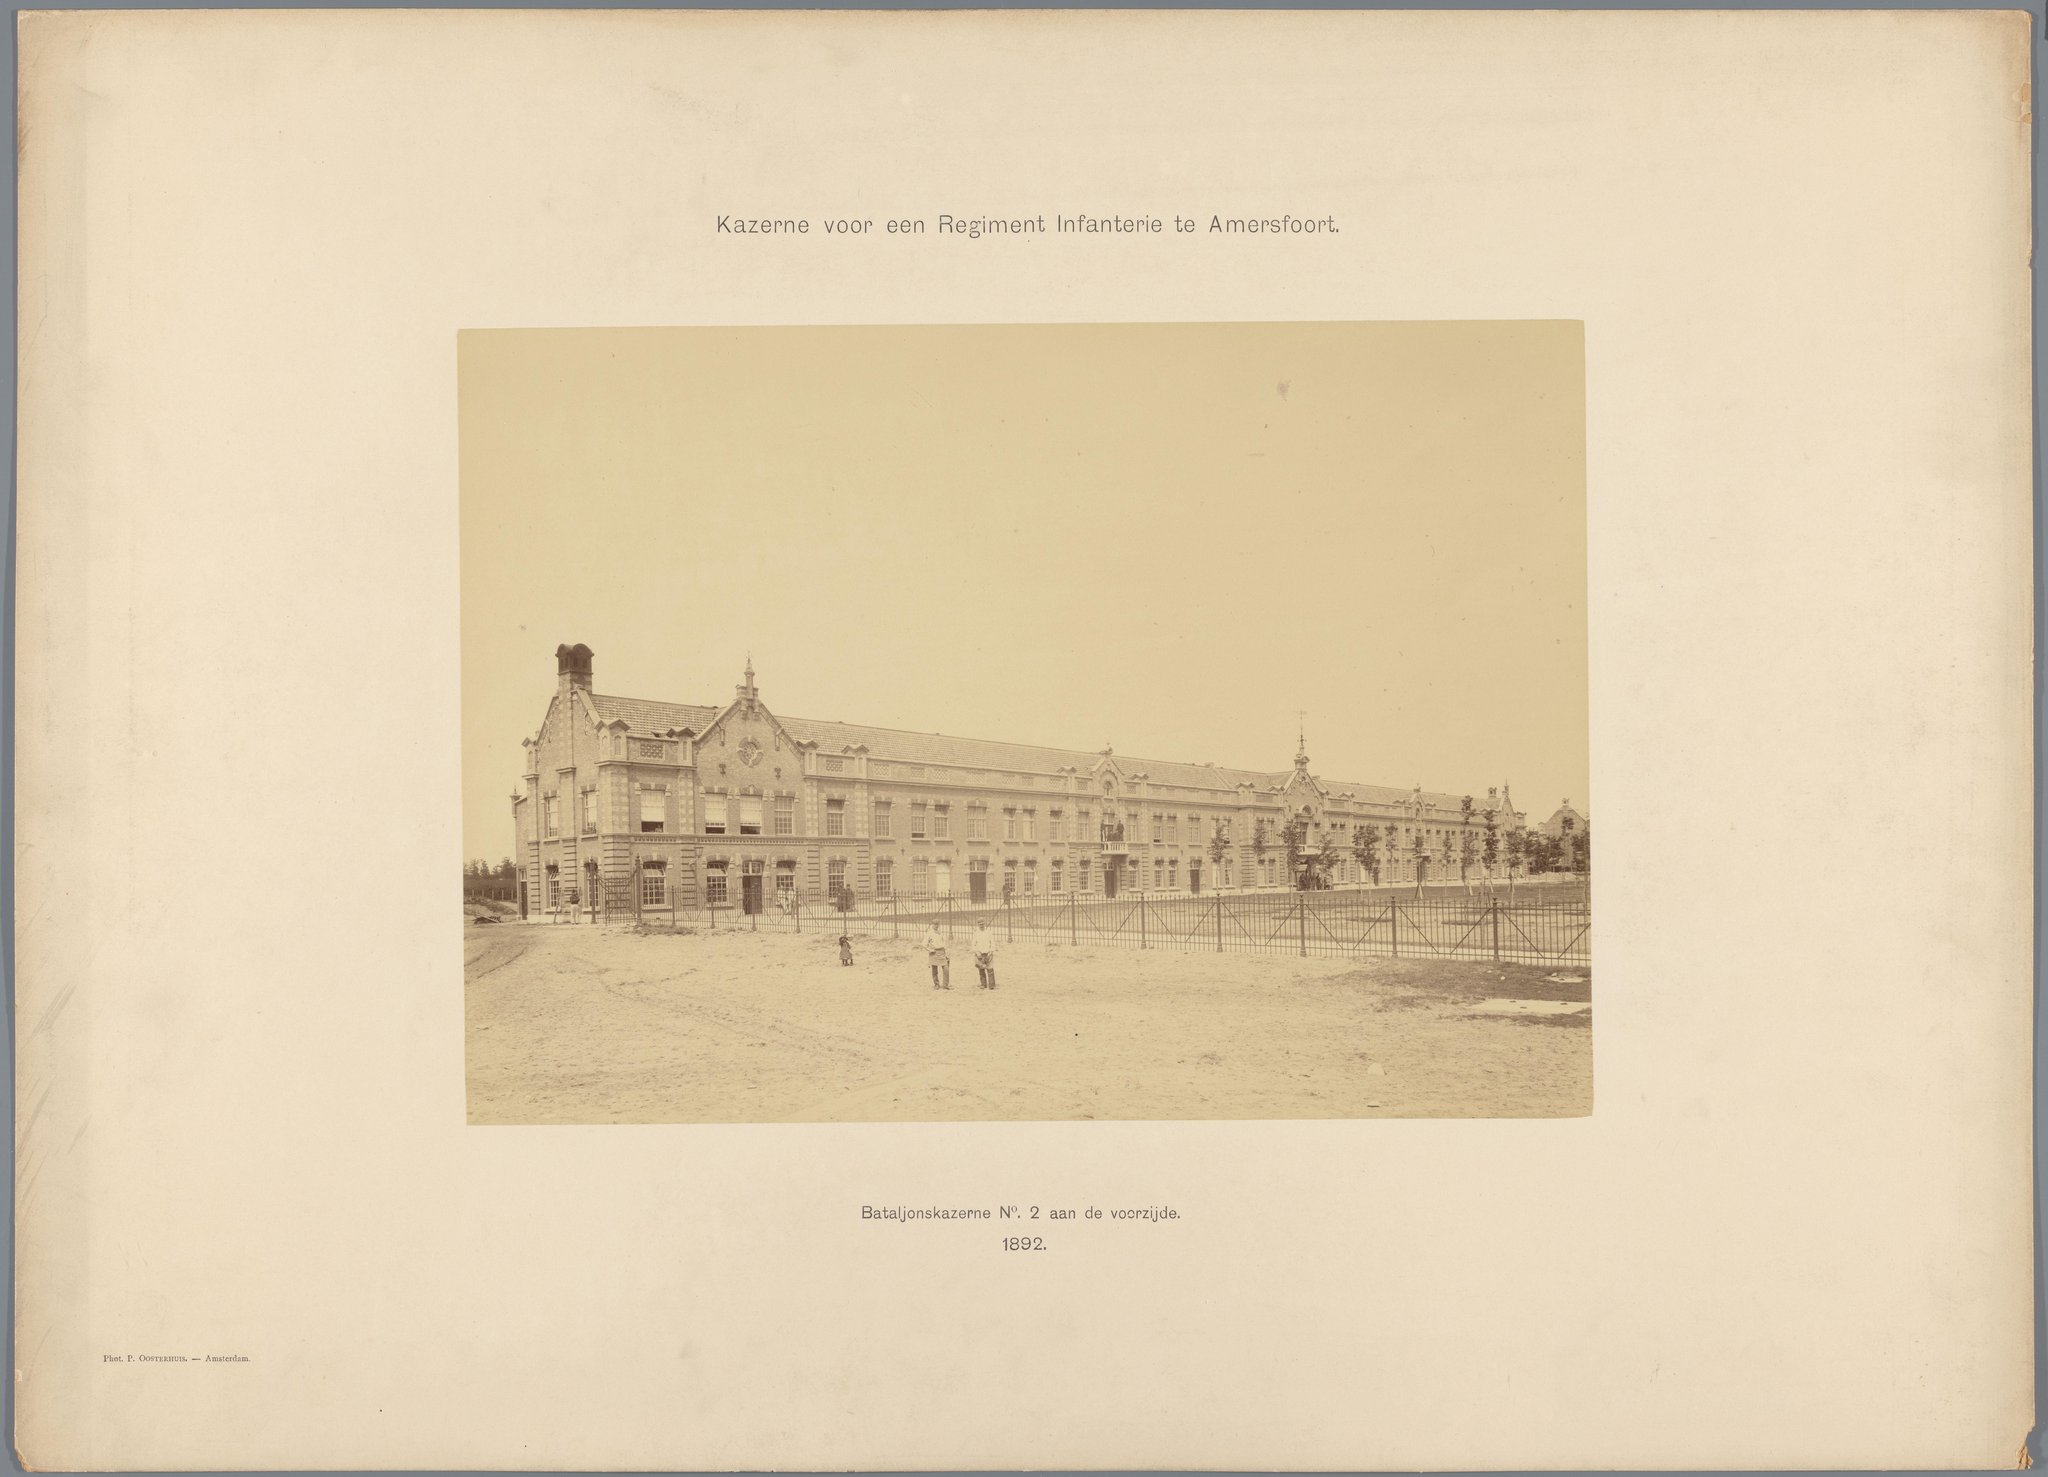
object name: photograph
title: Kazerne voor een Regiment Infanterie te Amersfoort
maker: p. oosterhuis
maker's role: fotograaf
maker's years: 1816-1885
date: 1892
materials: cardboard, paper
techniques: photography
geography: amersfoort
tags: netherlands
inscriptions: date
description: Foto, geelbruin, op karton, met boven titel en onder omschrijving. Opschrift; m.o.: '..Bataljonskazerne No 2..'